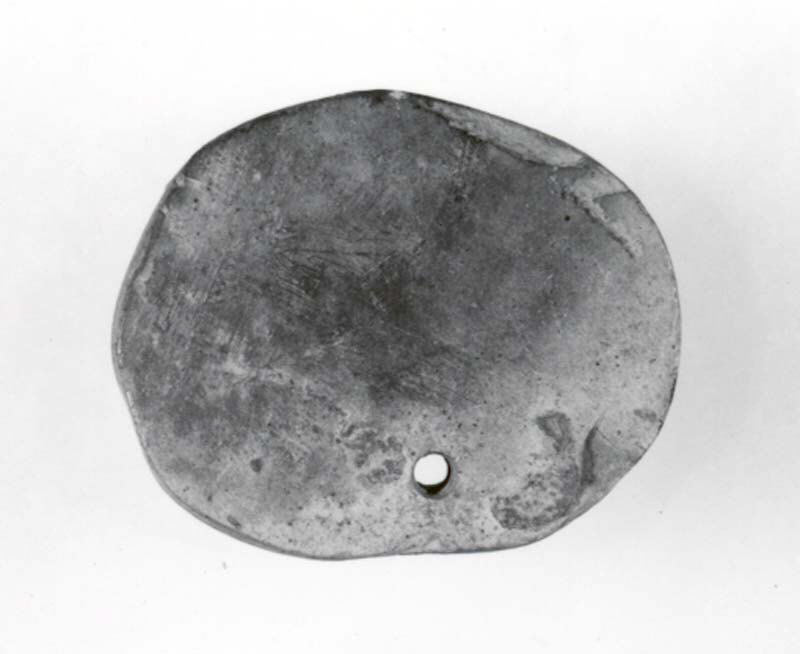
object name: necklace, bead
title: Amulet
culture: iranian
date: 2500-1750 BCE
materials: ceramic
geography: iran